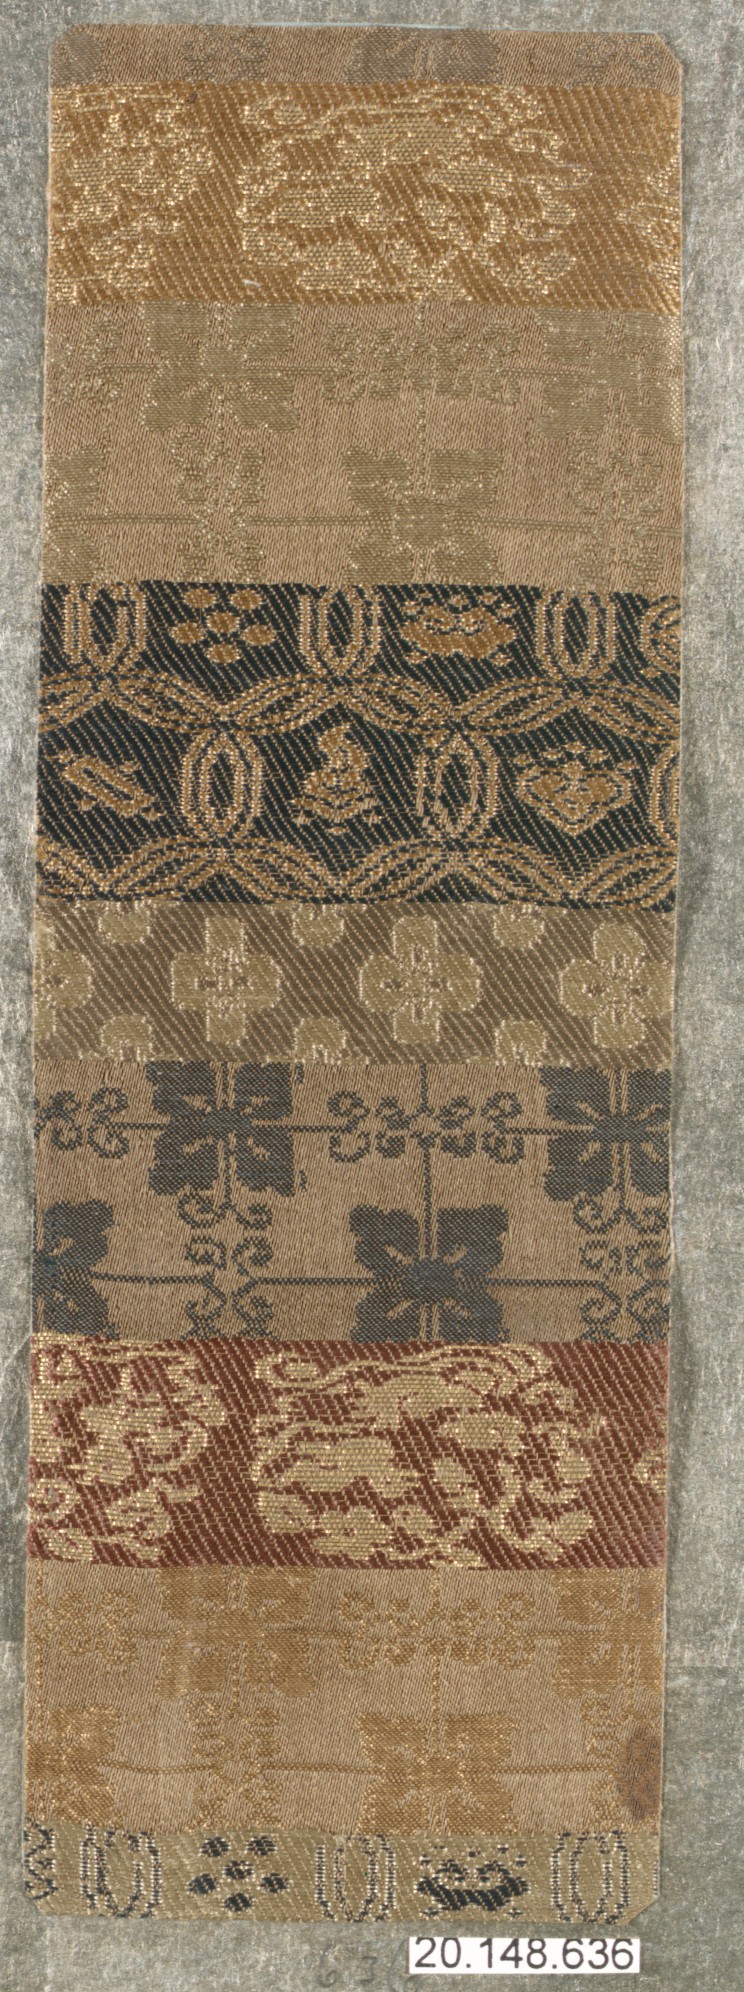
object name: piece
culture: japanese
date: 1701-1800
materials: silk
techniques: compound weave